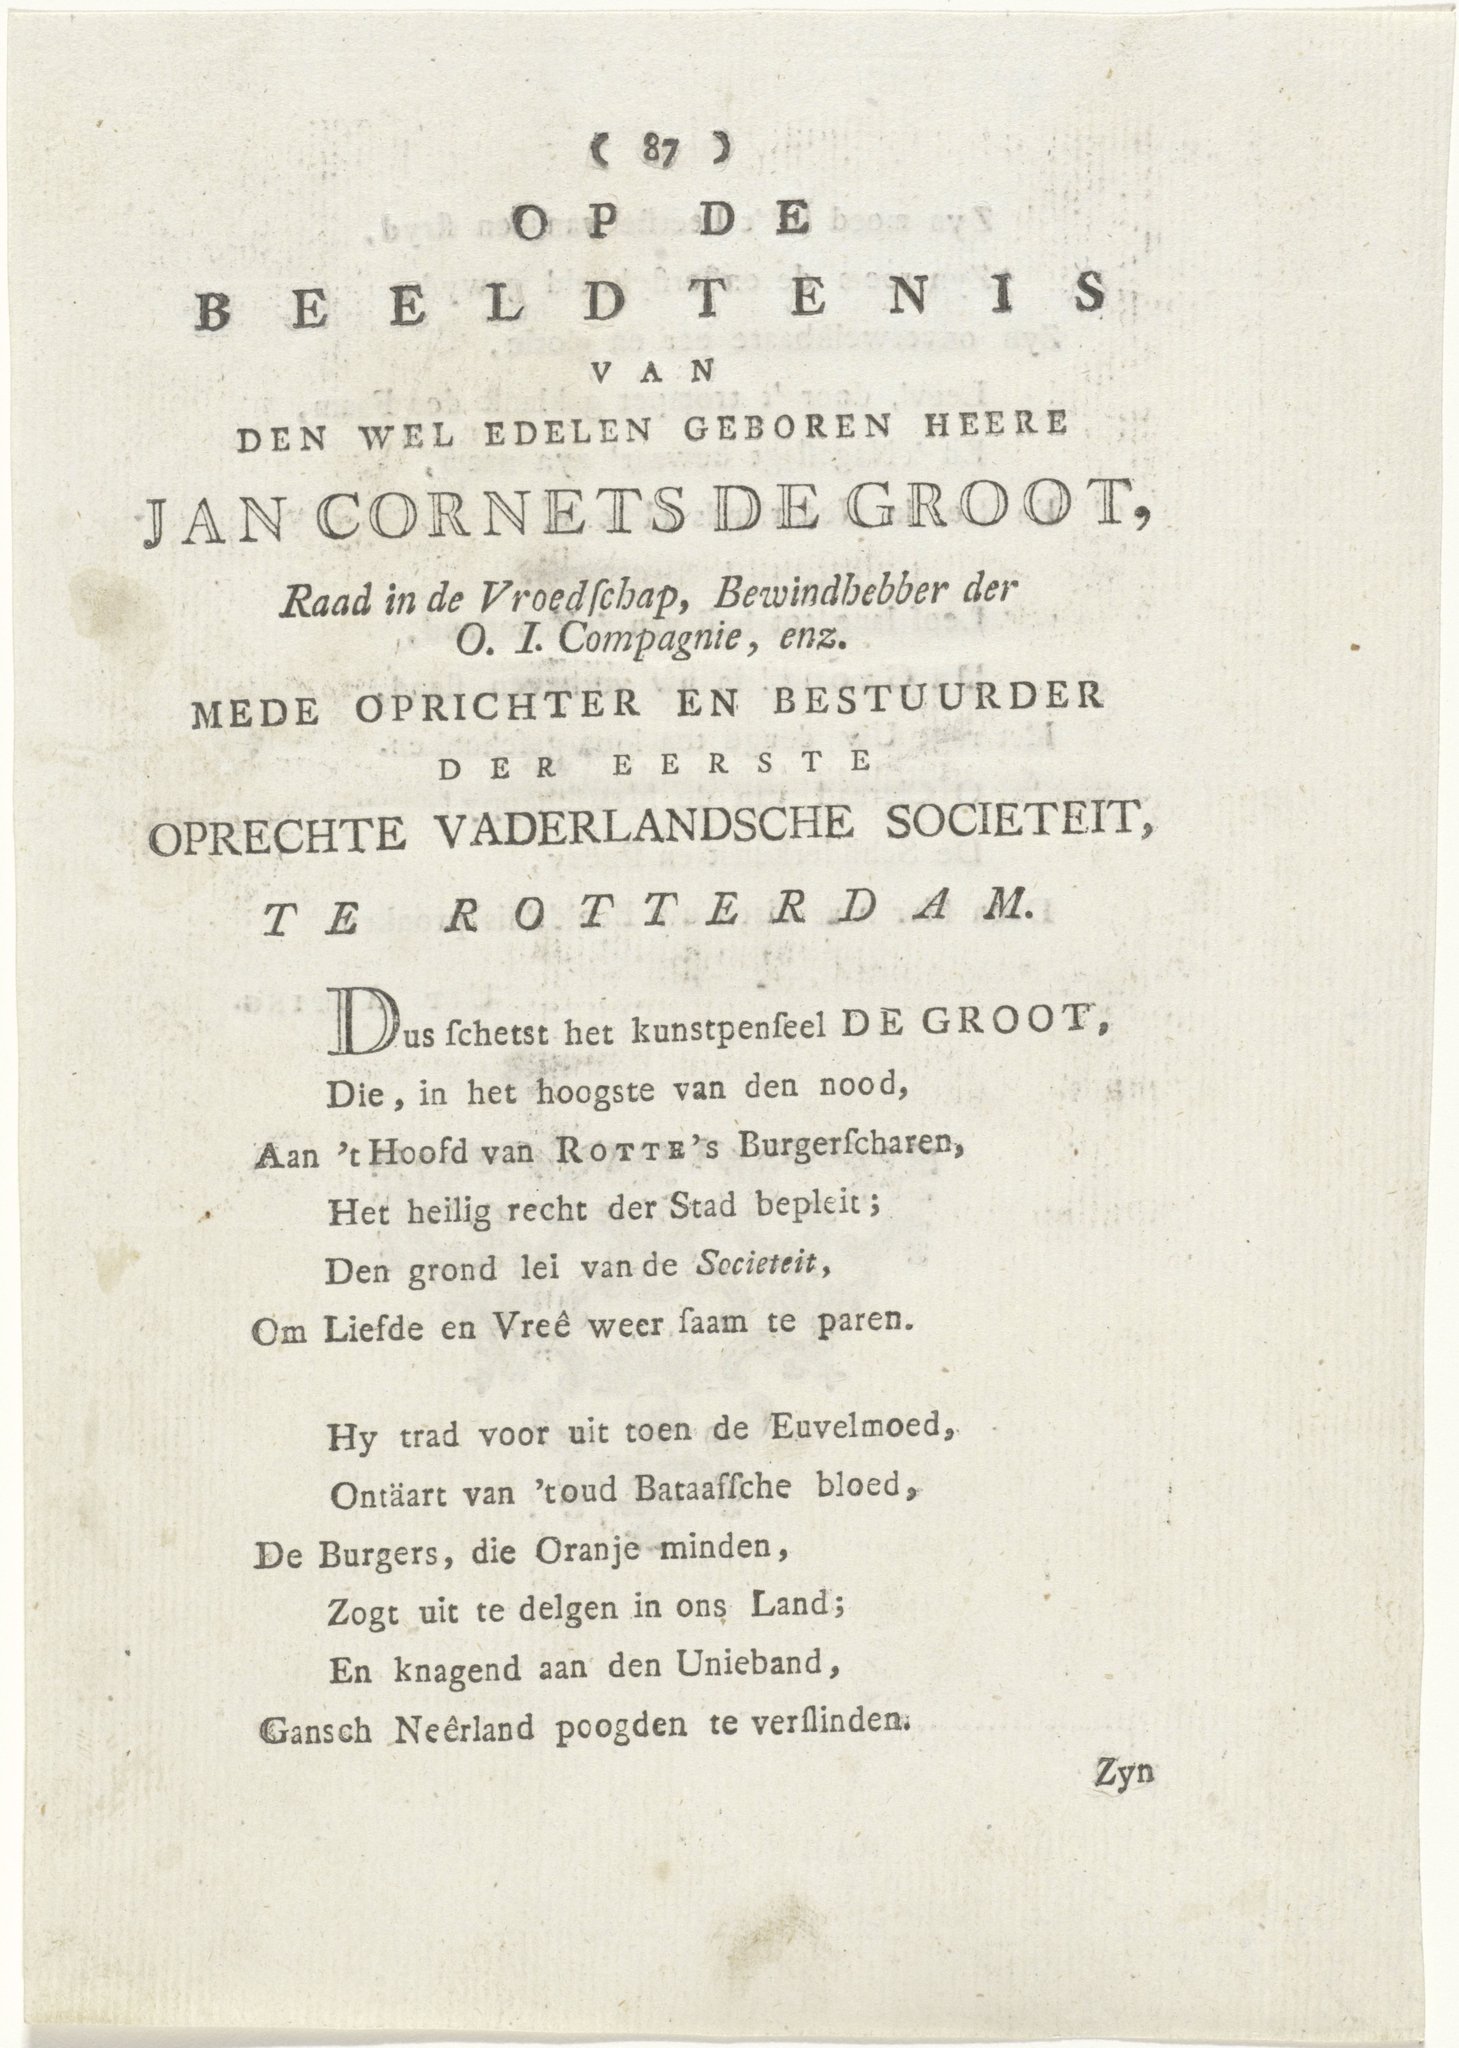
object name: print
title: Tekstblad met een lofdicht op Jan Cornets de Groot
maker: Anonymous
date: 1750-1800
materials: paper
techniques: letterpress printing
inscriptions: collector's mark: Lugt 2228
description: Recto en verso een tekstblad met een lofdicht op de bestuurder Jan Cornets de Groot (18de eeuw).